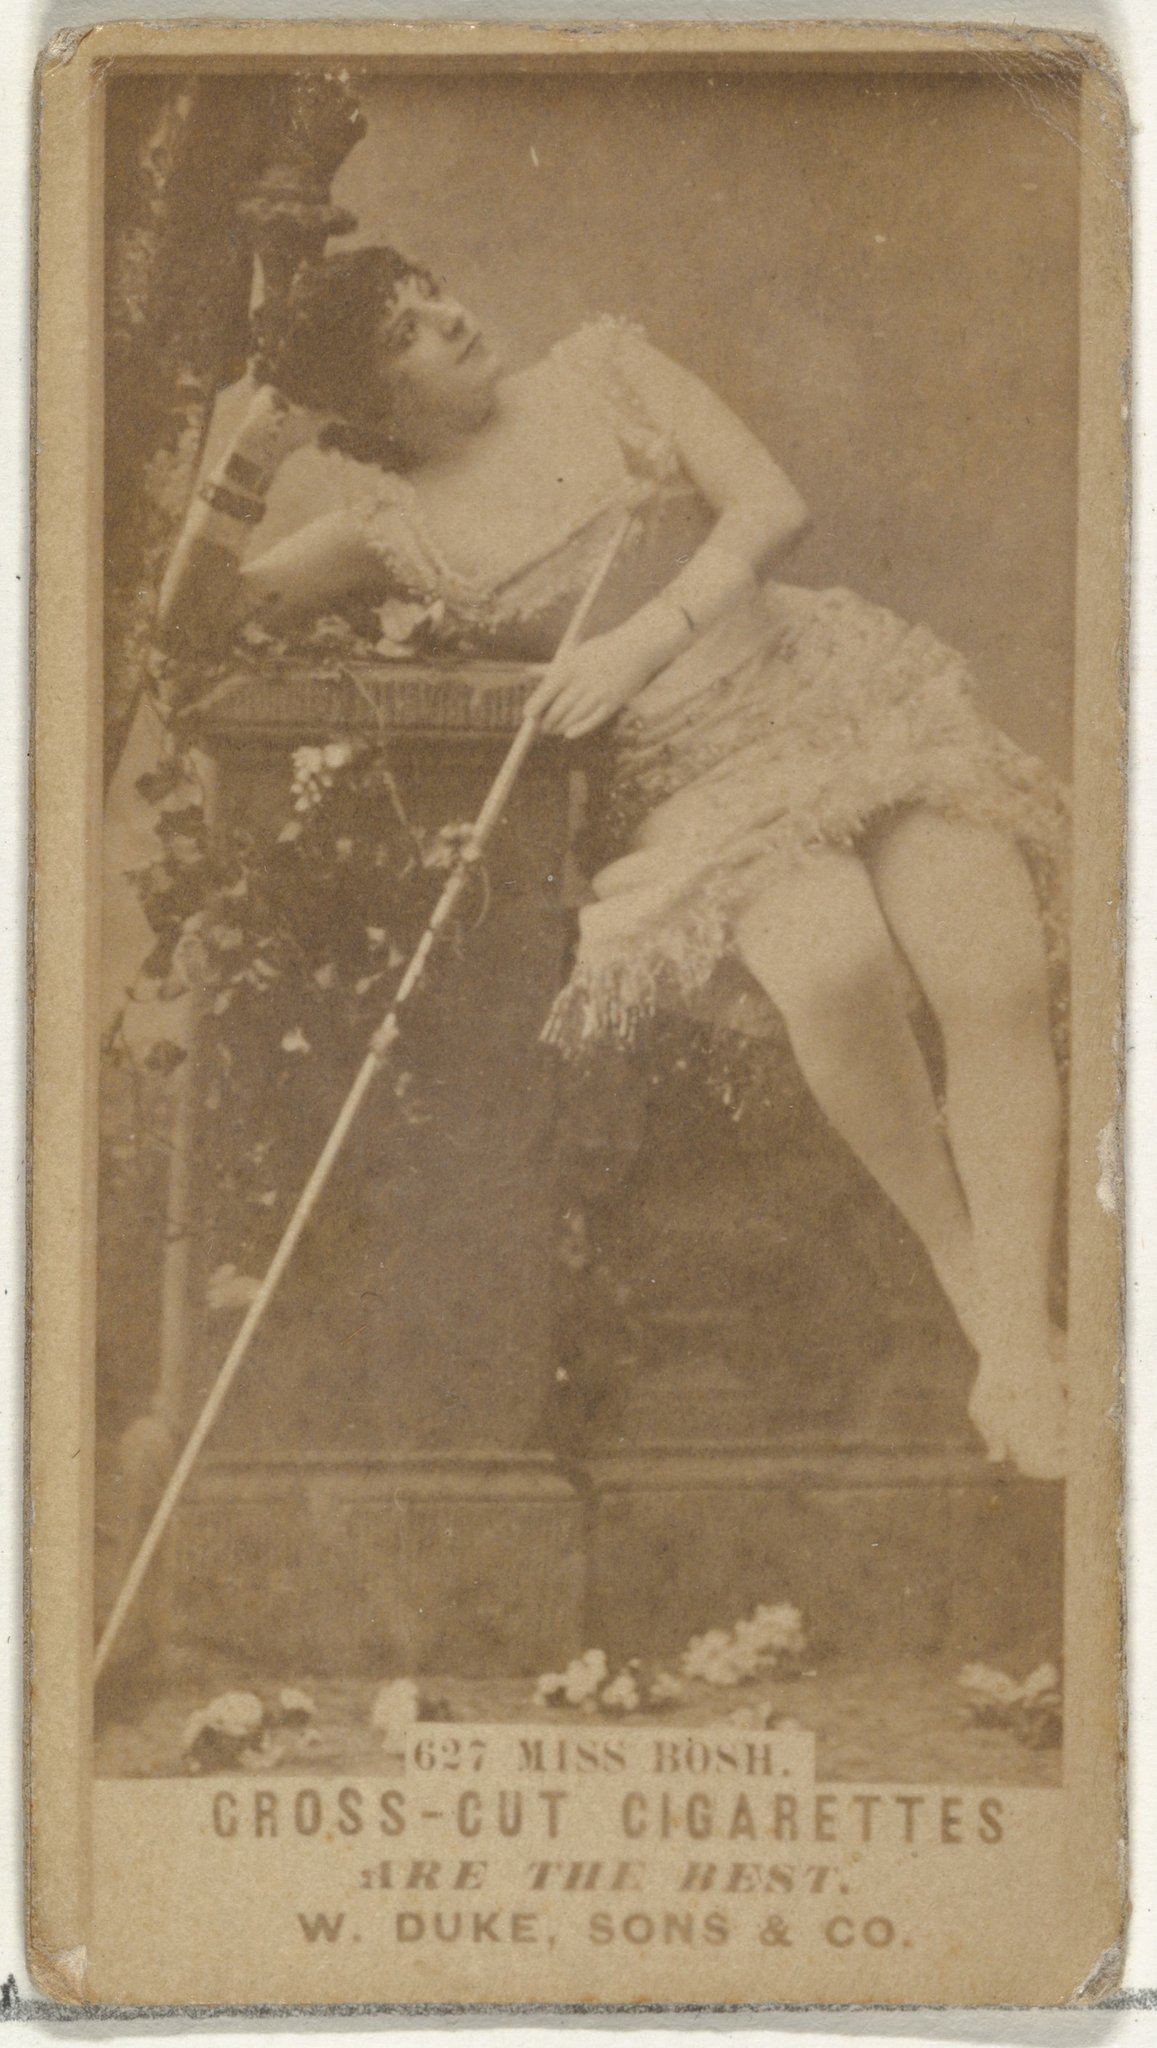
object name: photograph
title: Card Number 627, Miss Bosh, from the Actors and Actresses series (N145-3) issued by Duke Sons & Co. to promote Cross Cut Cigarettes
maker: w. duke, sons & co.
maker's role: publisher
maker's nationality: american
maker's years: 1870-1920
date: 1880-1889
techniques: albumen silver print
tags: portraits,women,actresses